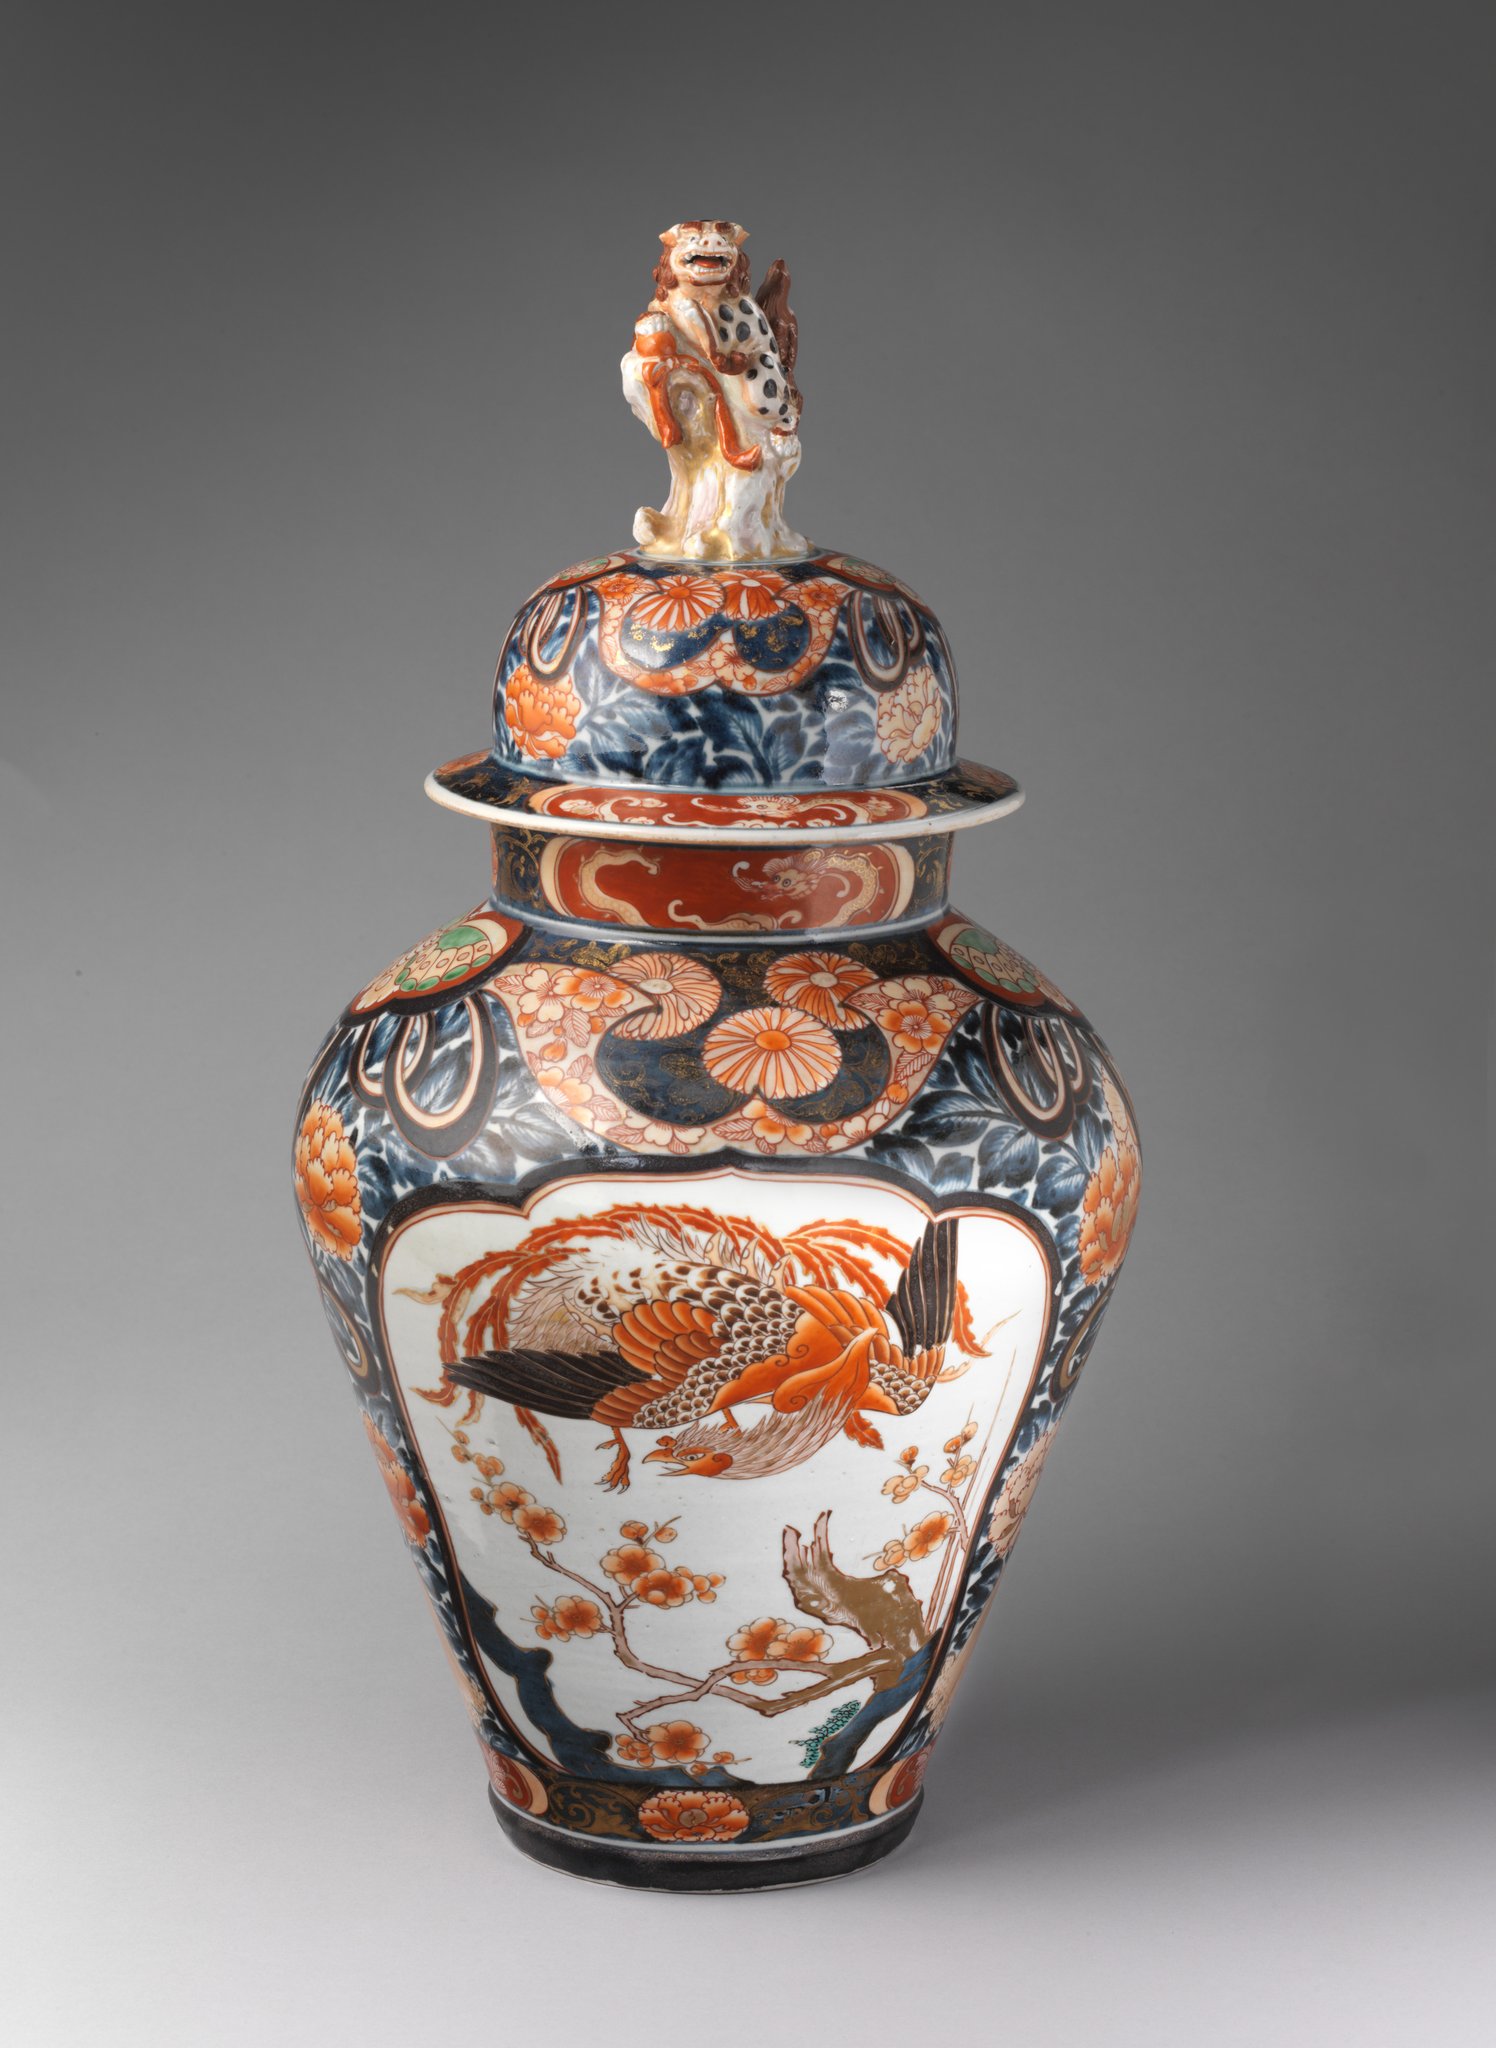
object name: vase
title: Baluster-shaped vase (part of a five-piece garniture)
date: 1690-1720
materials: enamel, hard paste porcelain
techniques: gilding, overglaze, underglaze